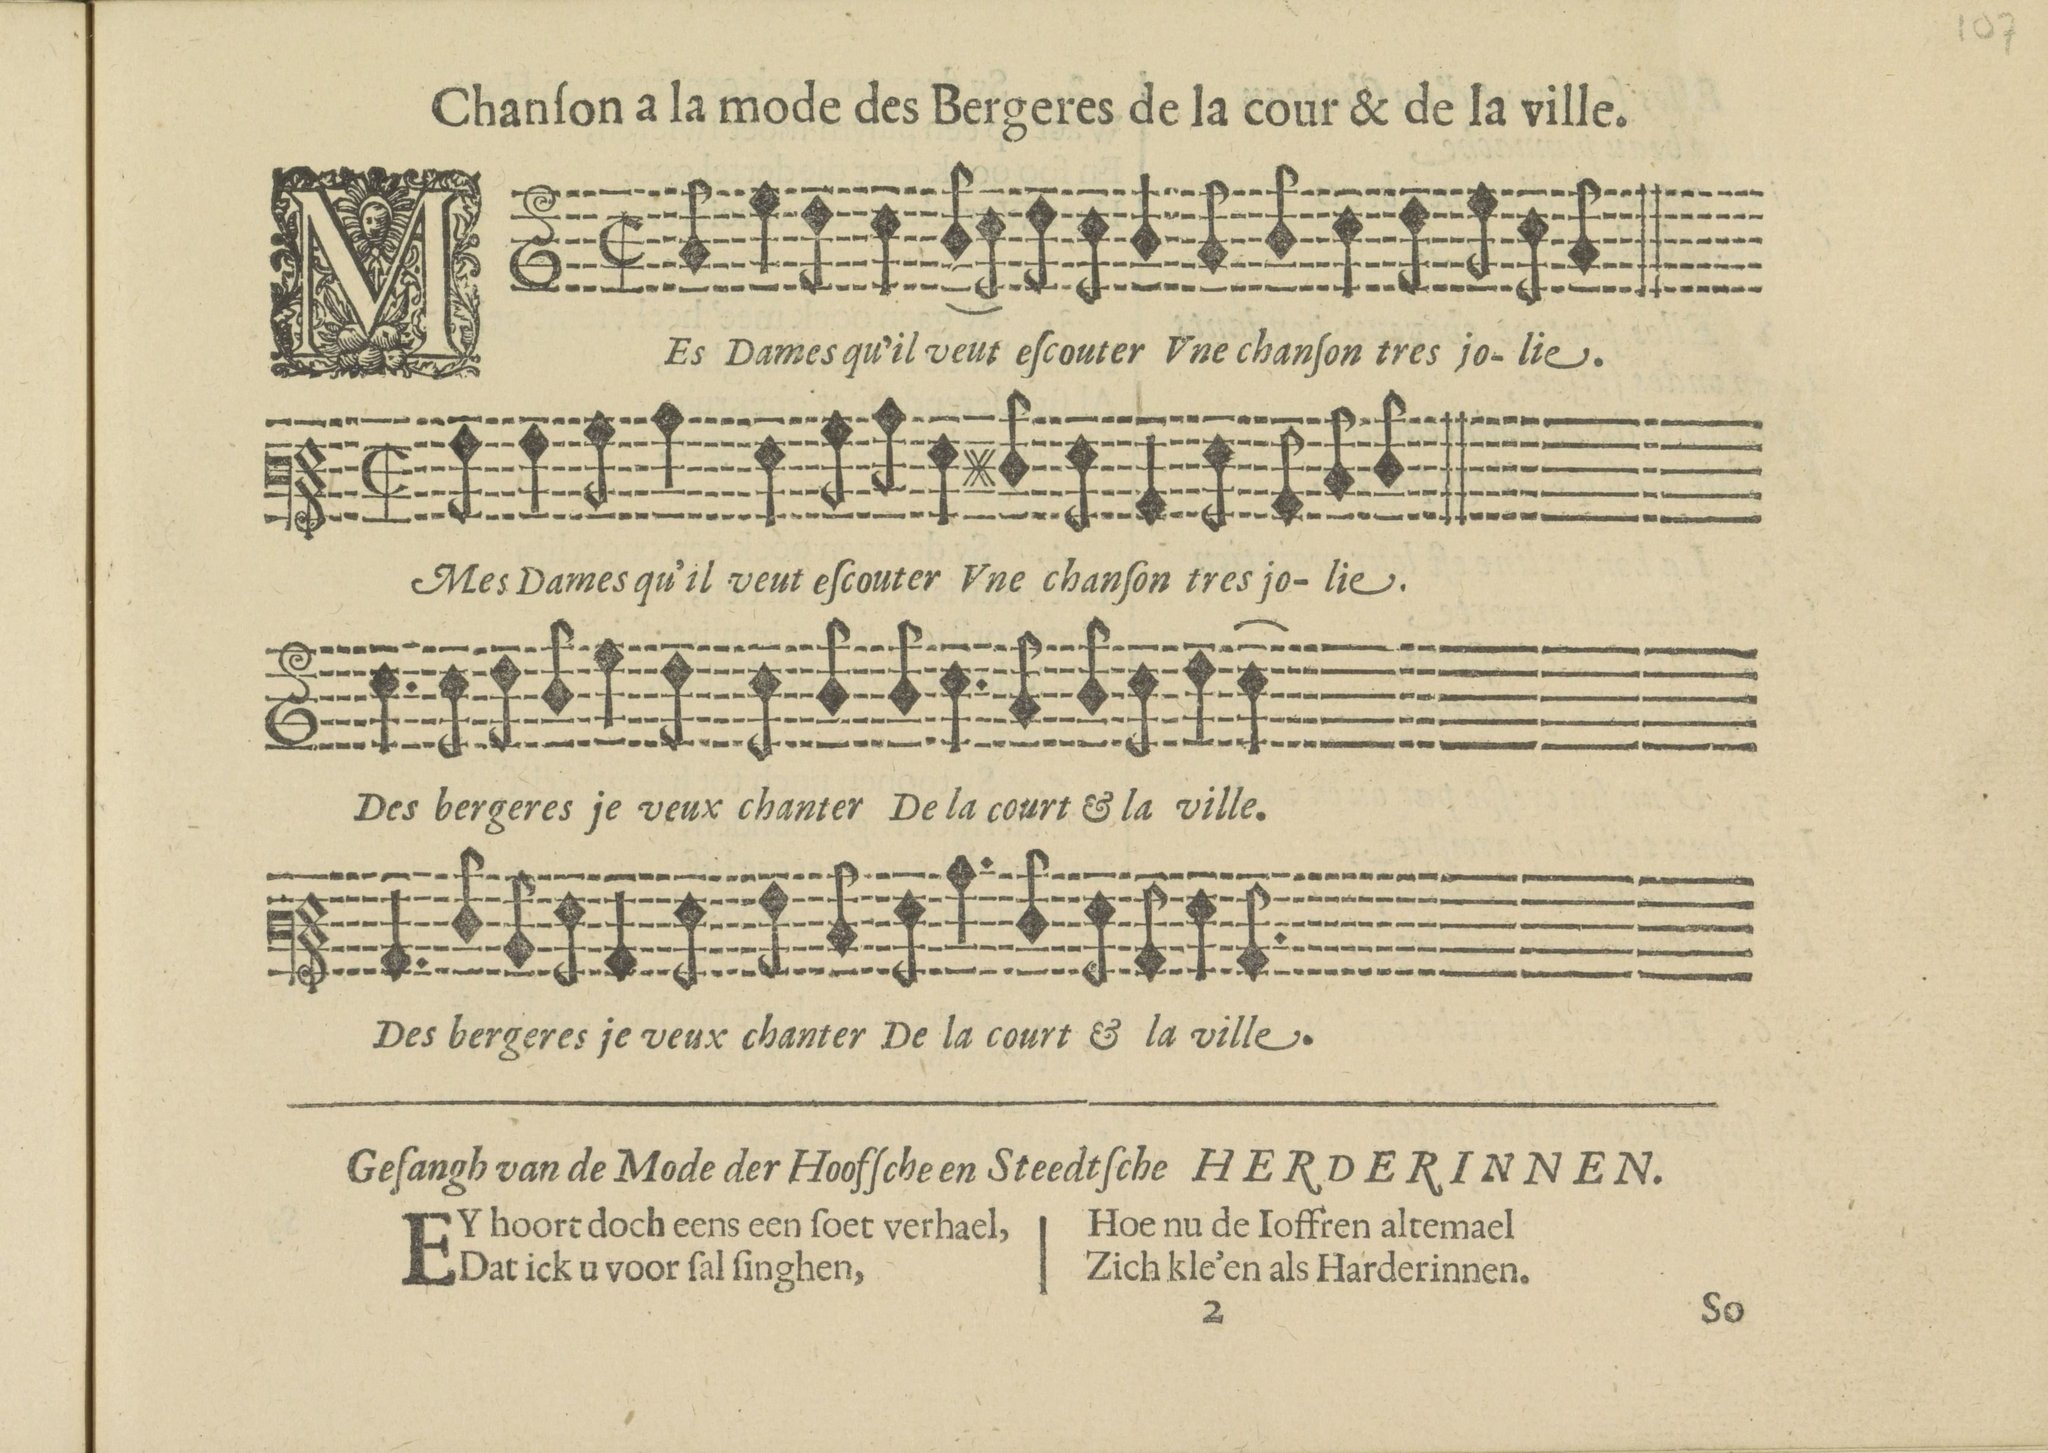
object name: album leaf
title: Les vrais pourtraits de quelques unes des plus grandes dames de la chrestiente desguisees en bergeres.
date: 1640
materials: paper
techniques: letterpress printing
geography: amsterdam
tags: initial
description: Gezang in tien Franstalige en Nederlandstalige kwatrijnen, op drie pagina's: pagina 1. Het eerste Franstalige kwatrijn onder vier notenbalken. De tekst begint met een gedecoreerde initiaal M. Het blad maakt deel uit van een album.